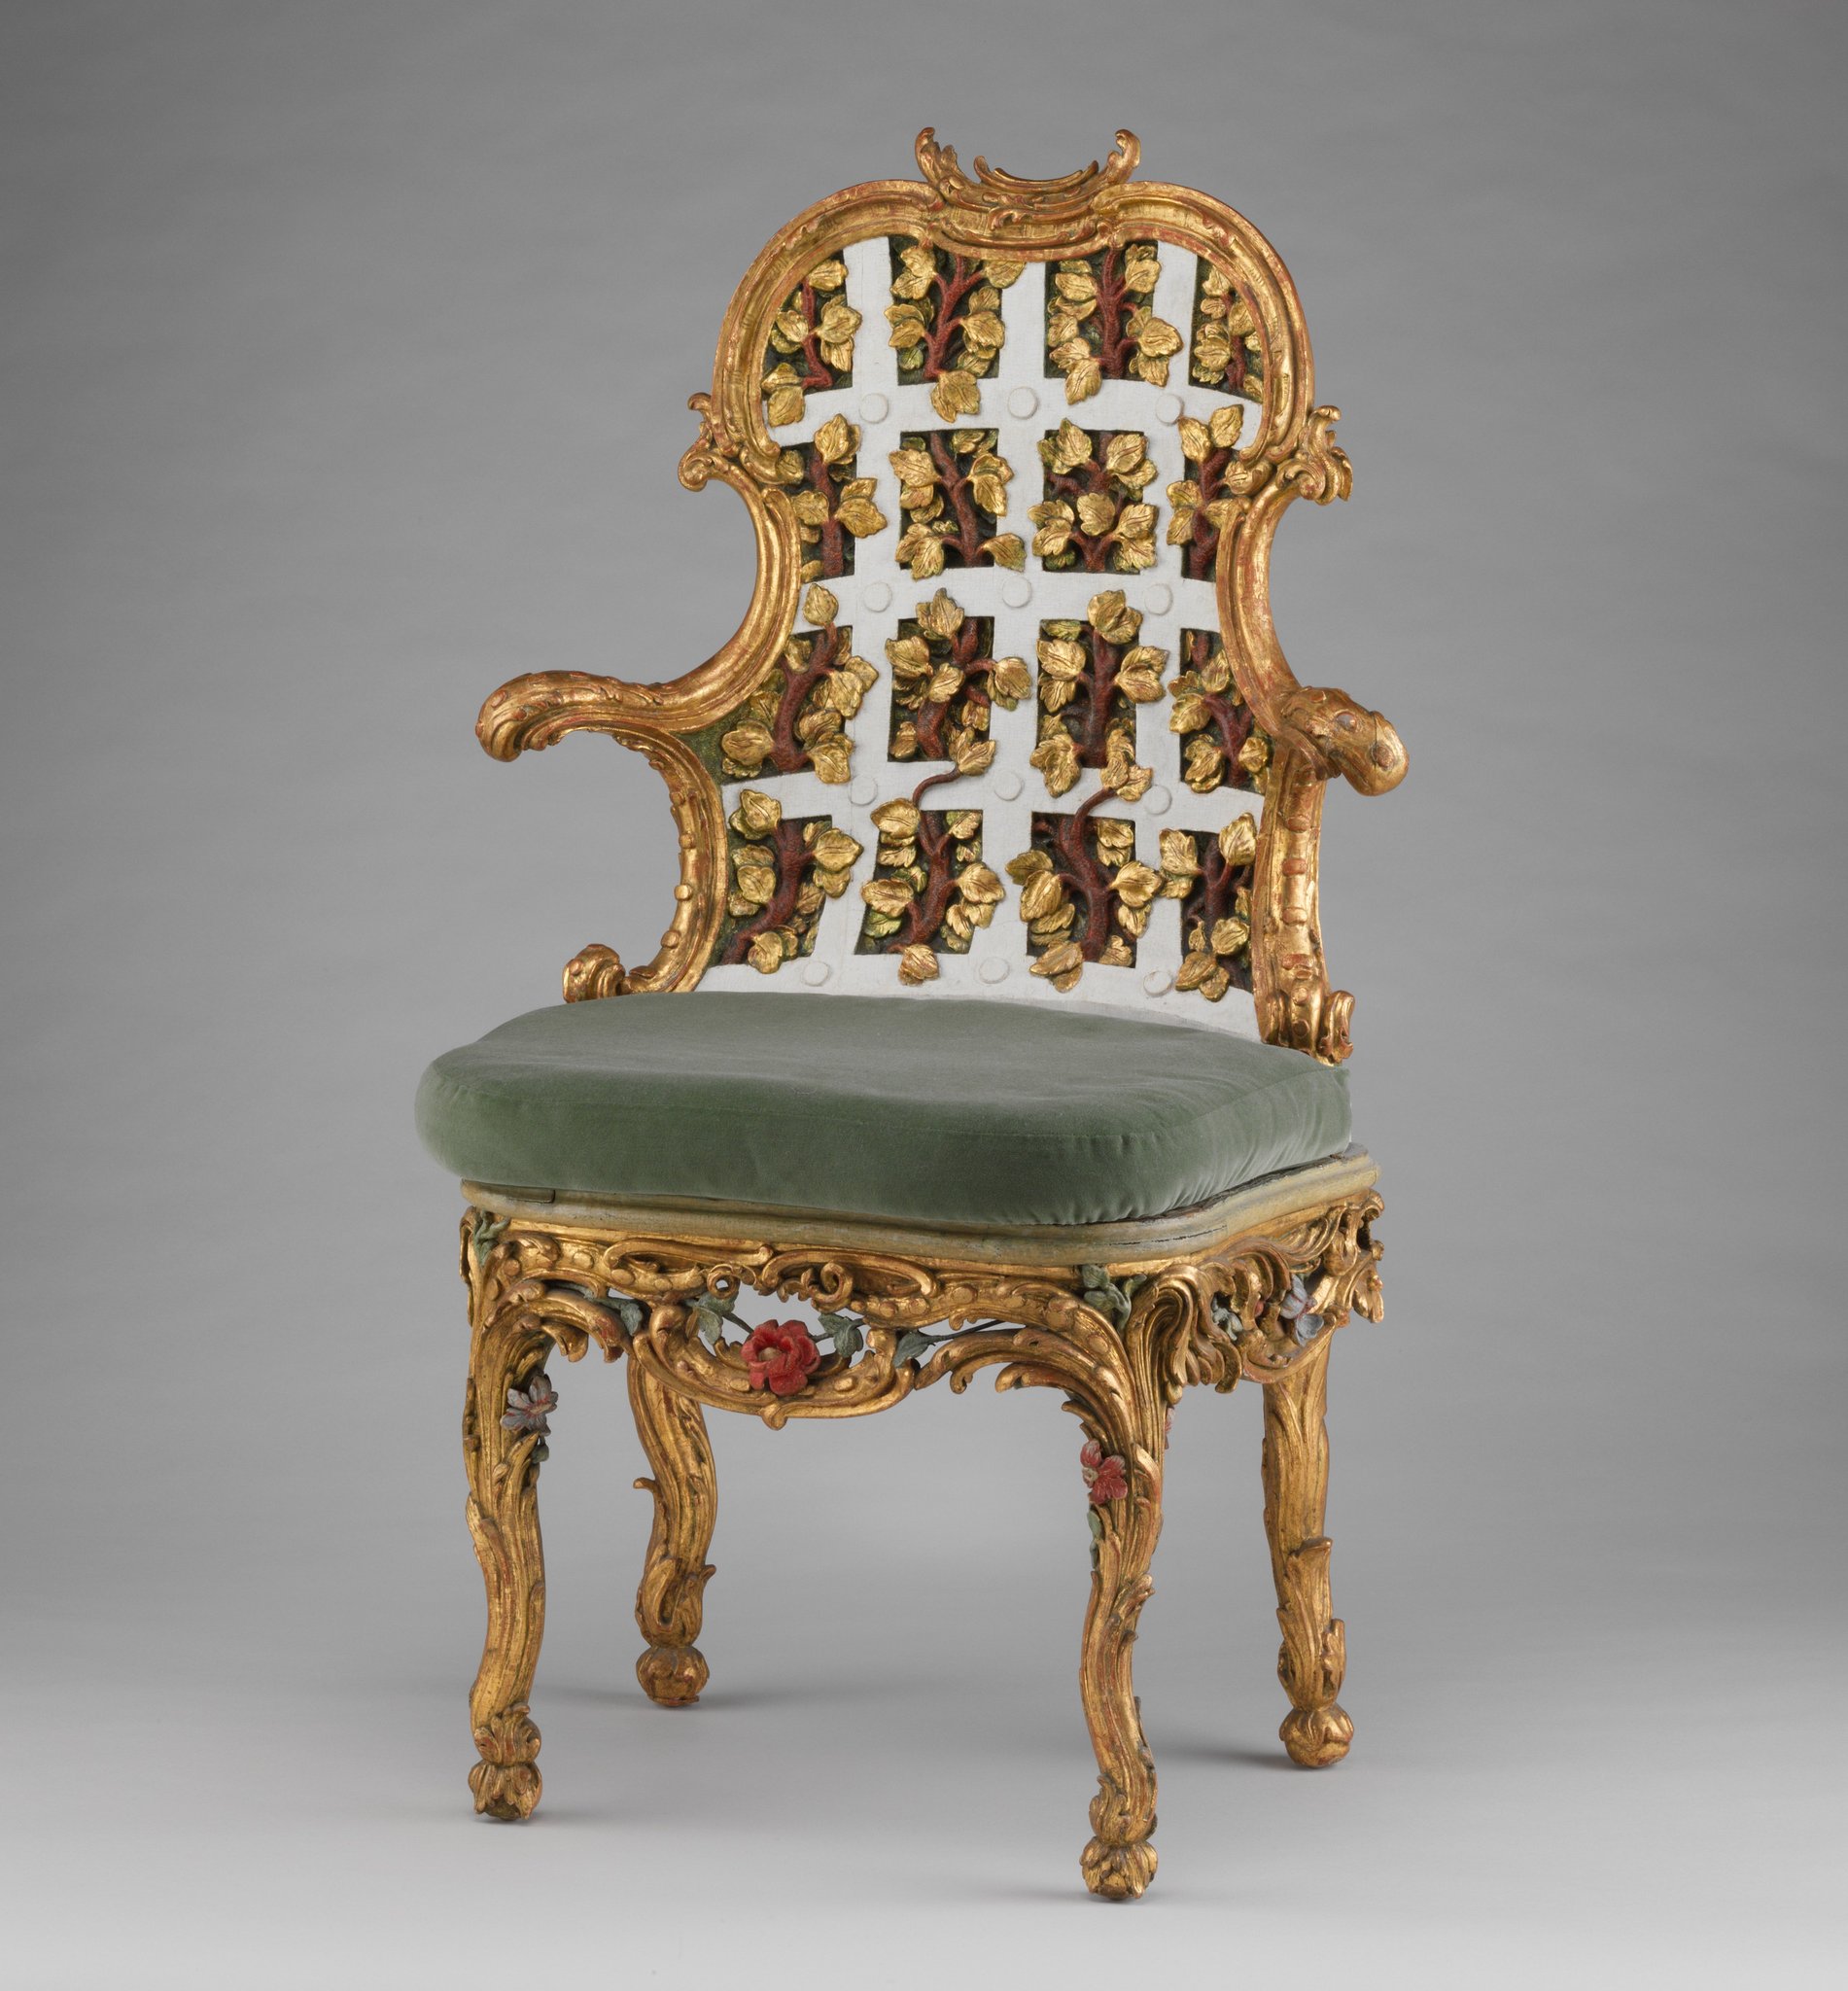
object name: armchair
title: Armchair (one of a pair) (part of a set)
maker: johann michael bauer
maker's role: maker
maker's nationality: german, born westheim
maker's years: 1710-1779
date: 1763-1764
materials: silk, velvet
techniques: carving, gilding, painting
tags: flowers